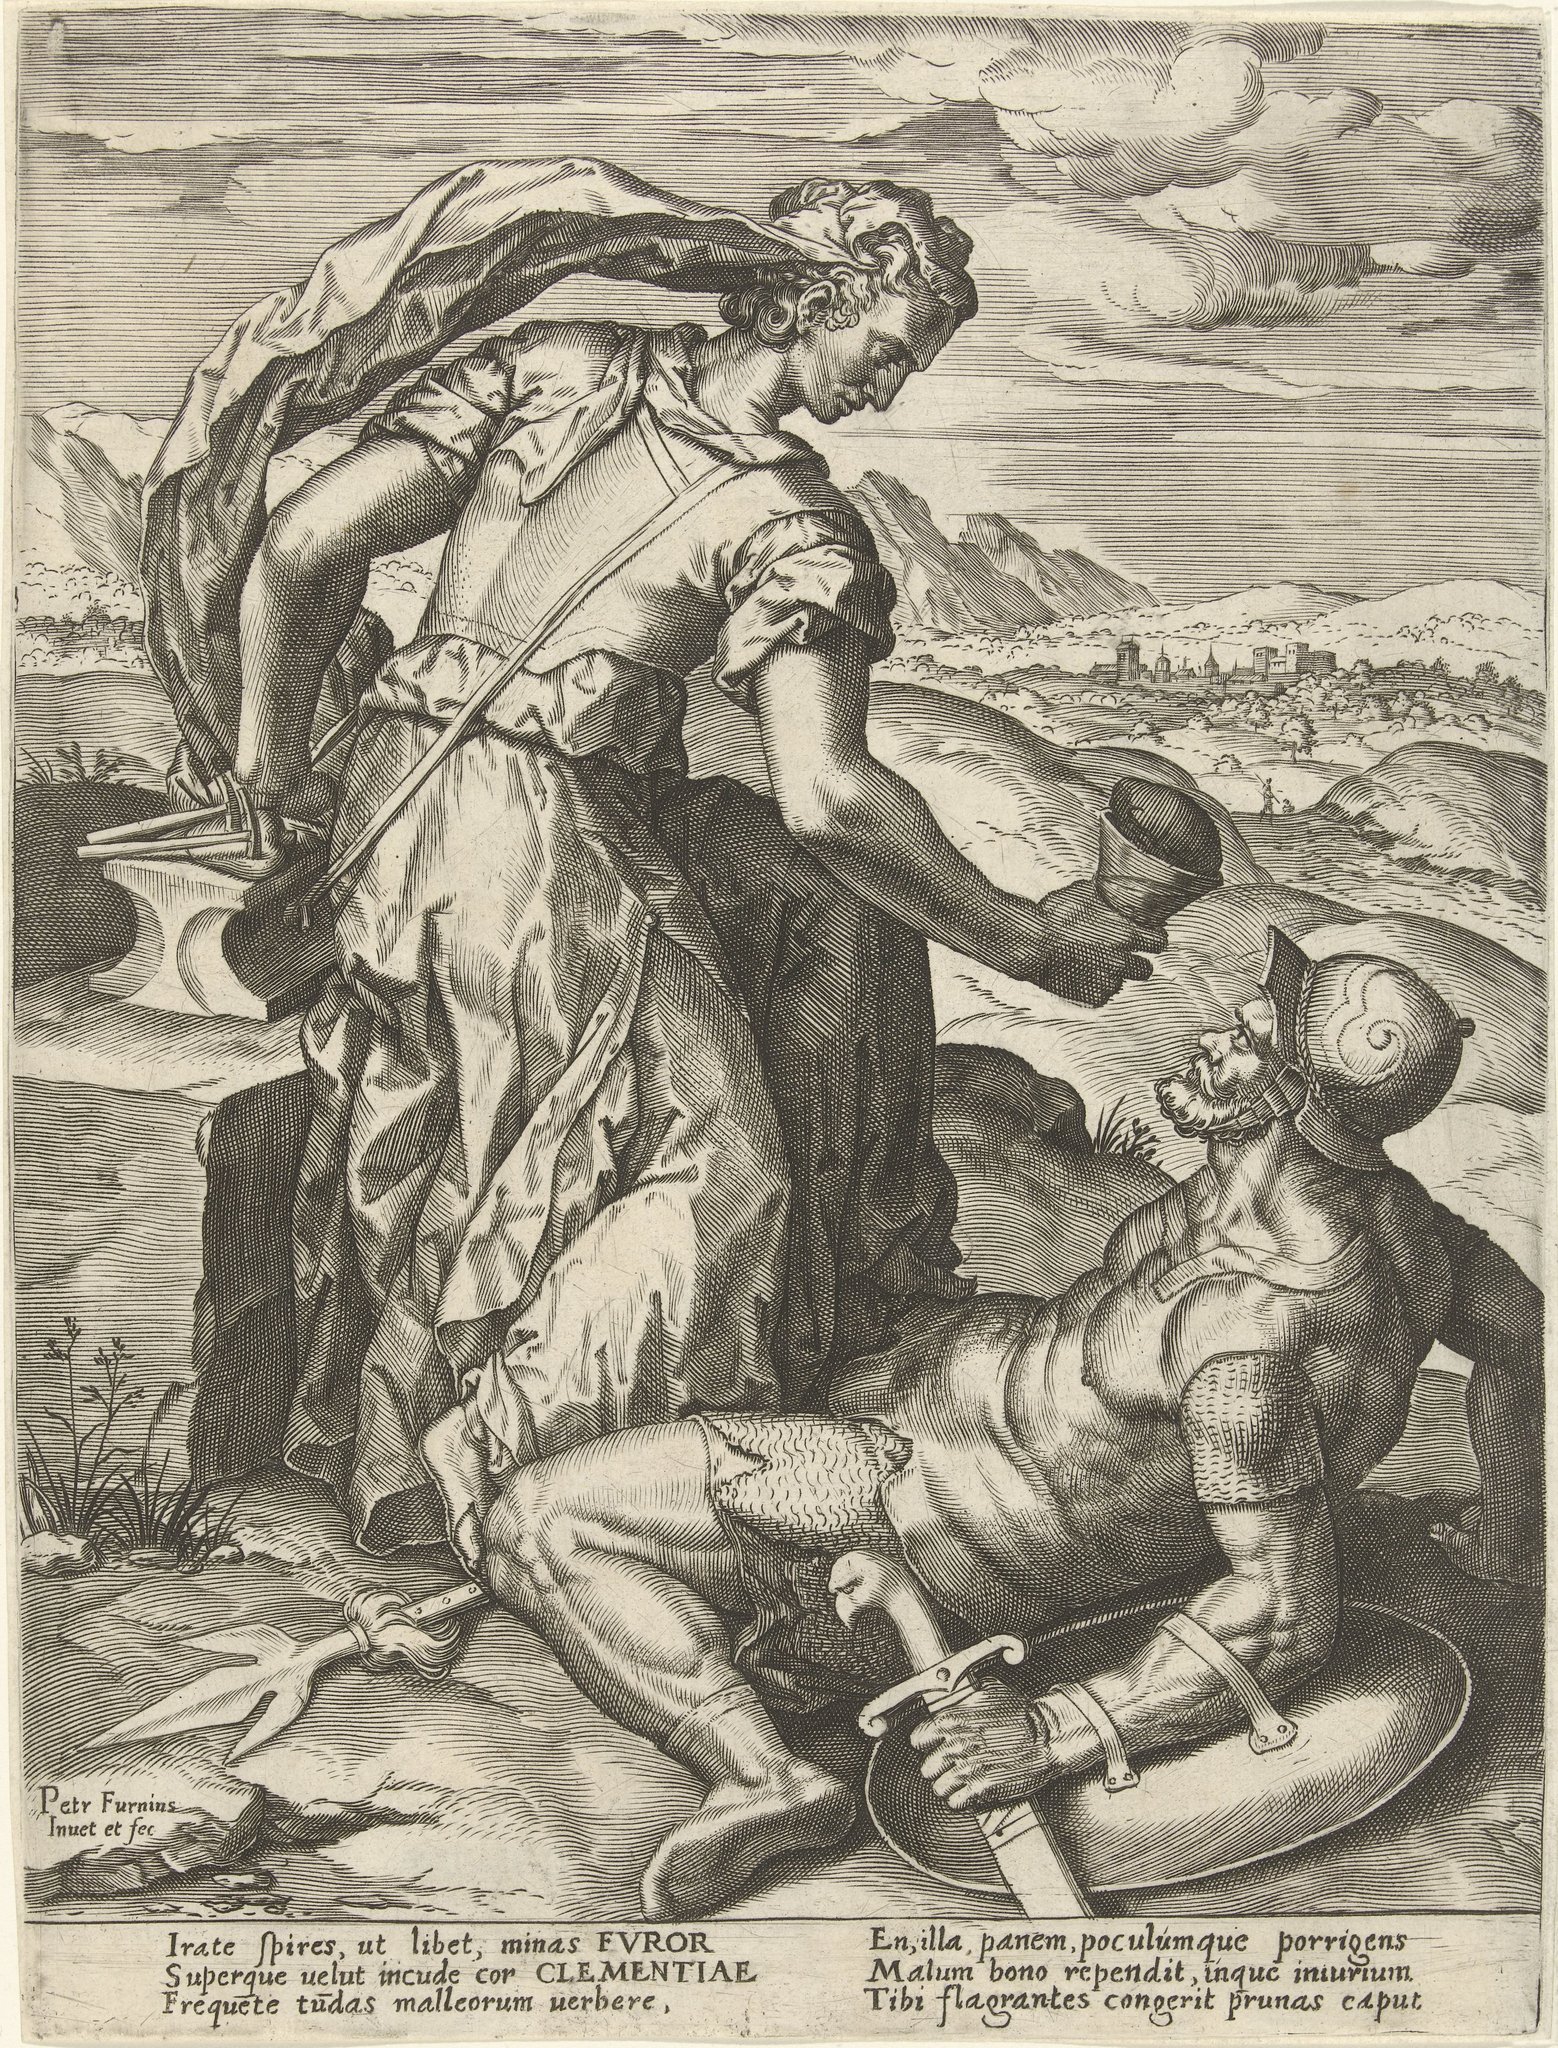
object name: print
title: Zachtmoedigheid overwint Razernij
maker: pieter jalhea furnius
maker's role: print maker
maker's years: 1540-1626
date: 1550-1625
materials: paper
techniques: engraving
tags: anger; 'ira' (ripa) ~ personification of one of the seven deadly sins, one virtue fighting against or treading upon one vice, indulgence, clemency; 'clemenza', 'clemenza & moderatione', 'indulgenza' (ripa)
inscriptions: collector's mark: Lugt 2228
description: De personificatie van Razernij (Furor) ligt op de grond aan de voeten van Zachtmoedigheid (Clementia). De prent heeft een Latijns onderschrift en maakt deel uit van een serie over deugden en ondeugden.